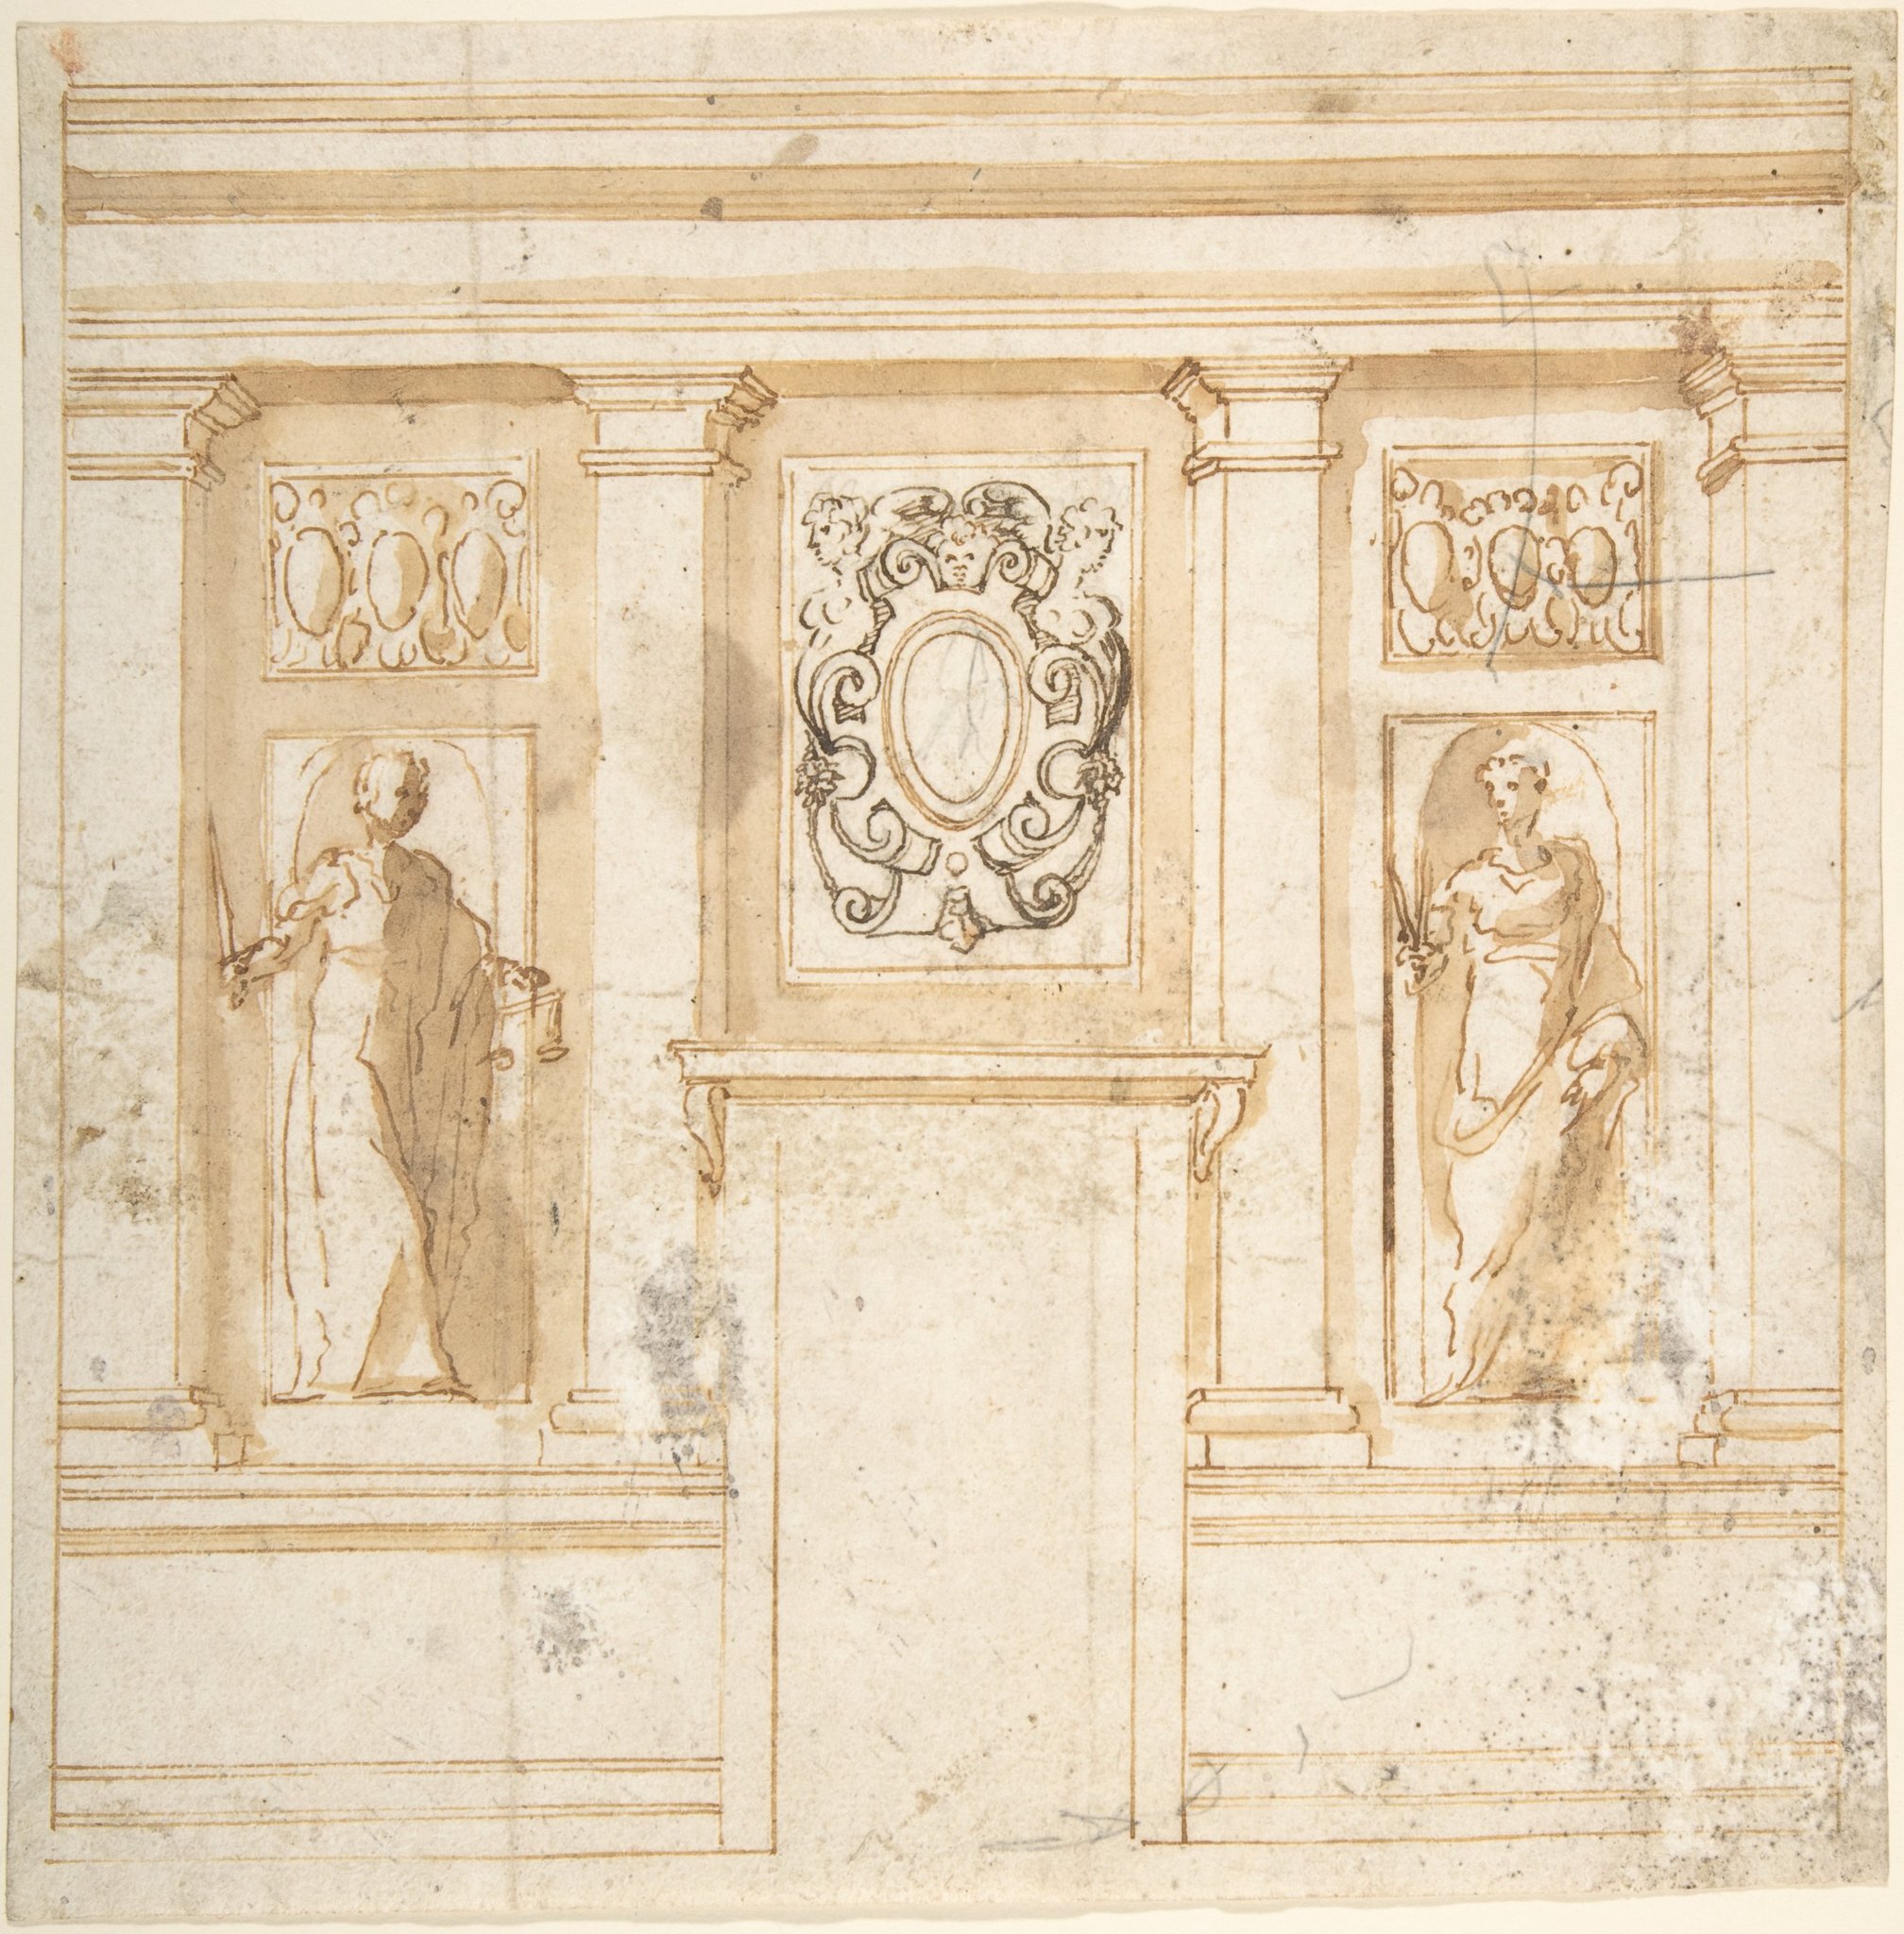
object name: drawing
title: Elevation of a wall with partial pilasters, reliefs, and niche figures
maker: anonymous, italian?, 16th century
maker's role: artist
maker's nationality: italian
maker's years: 1500-1600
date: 1501-1600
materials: ink, drawing material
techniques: brush, pen, drawing, wash